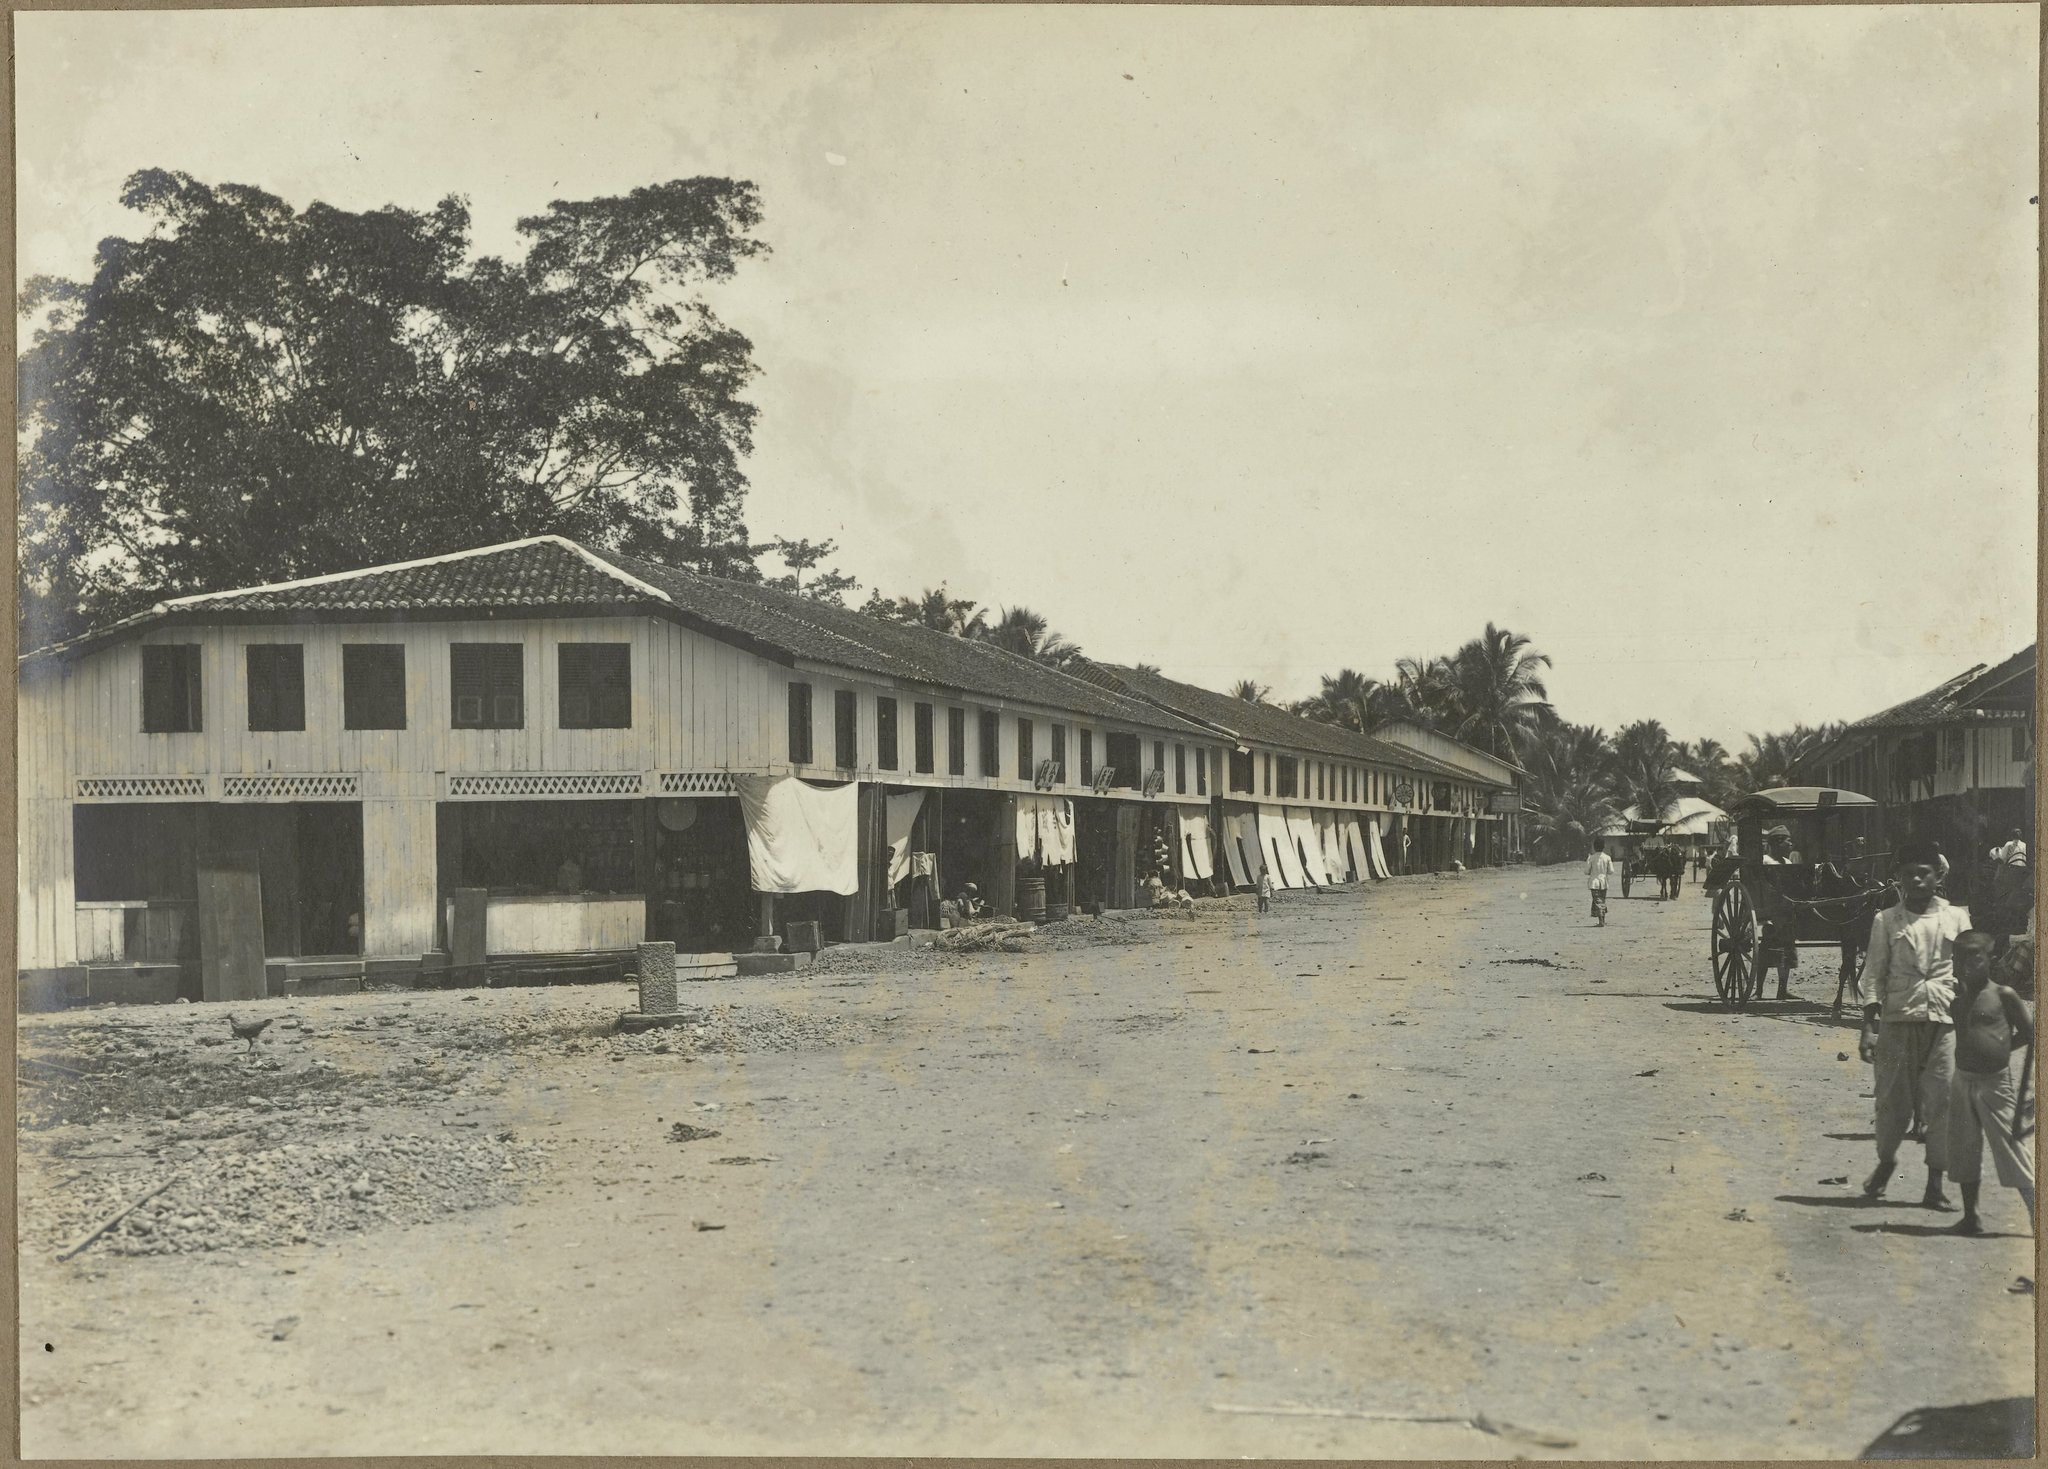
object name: photograph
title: Straatgezicht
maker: Anonymous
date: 1914-1919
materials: photographic support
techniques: gelatin silver print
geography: medan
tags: representation of real building (either existing or having existed), architecture, public road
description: Gezicht in een straat, waarschijnlijk te Medan, met gebouwen die kenmerkend zijn voor de lokale bouwstijl. Foto in het fotoalbum van het Nederlandse architectenbureau en aannemersbedrijf Bennink en Riphagen te Medan in de jaren ca. 1914-1919.